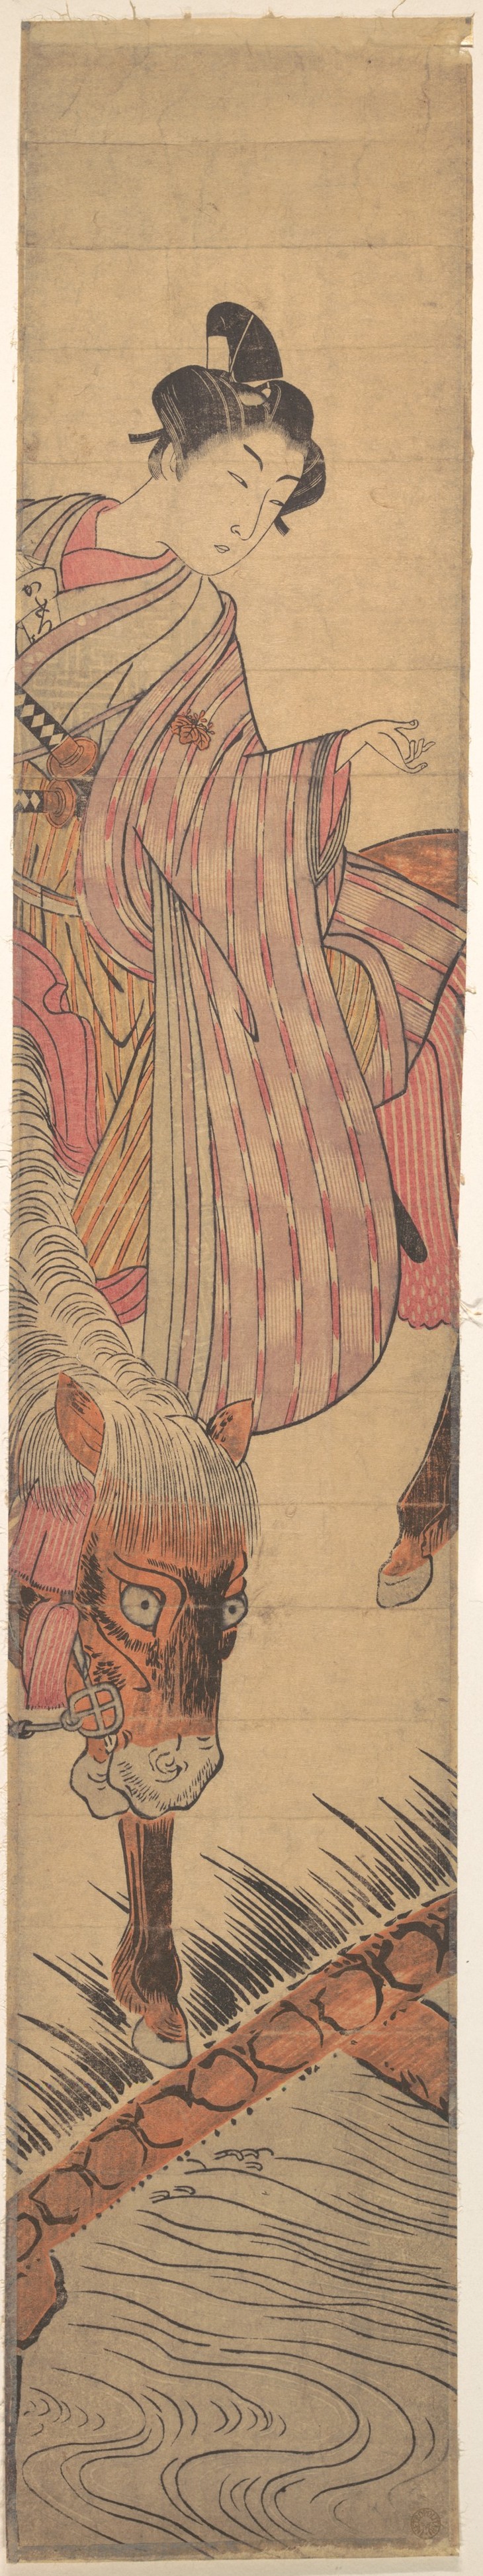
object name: print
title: Nitate Sekko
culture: japanese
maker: isoda koryūsai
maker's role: artist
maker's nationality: japanese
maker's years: 1735-1790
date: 1770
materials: ink, paper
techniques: woodblock print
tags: women,horses